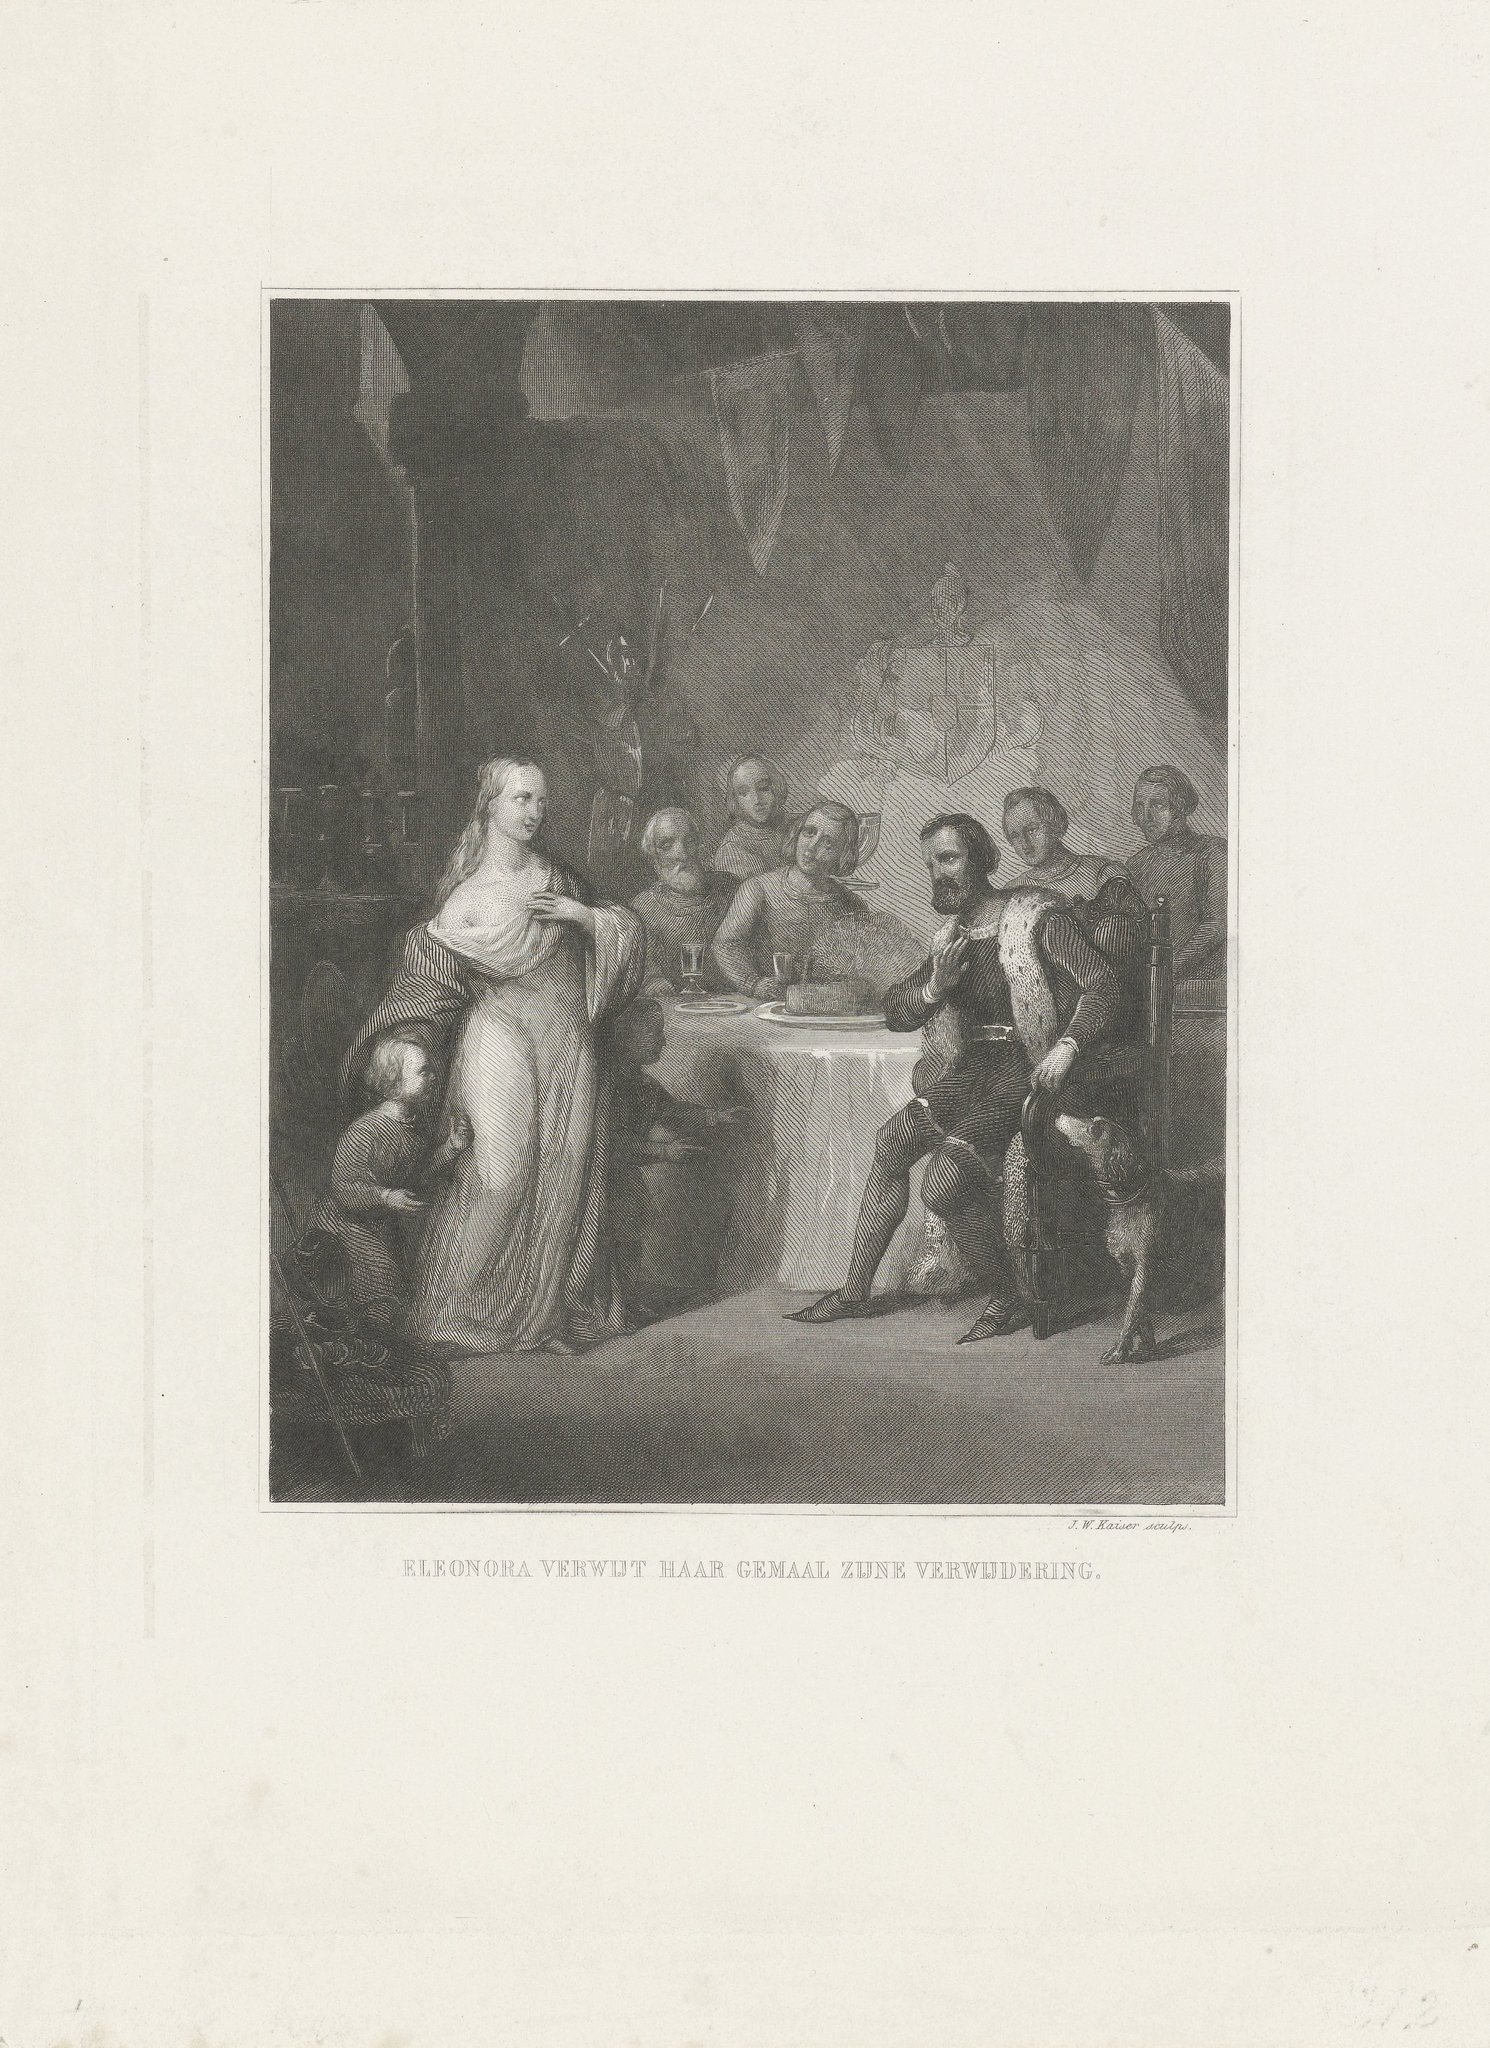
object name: book illustration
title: Eleonora verwijt haar gemaal zijne verwijdering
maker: johann wilhelm kaiser (i)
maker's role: draughtsman, print maker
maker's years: 1813-1900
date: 1840-1884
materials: paper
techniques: engraving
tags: arnhem, deventer, nijmegen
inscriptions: collector's mark: Lugt 2228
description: Eleonora van Engeland verwijt in Nijmegen haar man graaf Reinoud II van Gelre zijn verwijdering in het jaar 1342. Zij bewijst haar man dat zij niet melaats is en dat hij haar dus ten onrechte heeft verstoten. Zij voorspelt de ondergang van zijn huis, beide zonen die naast haar staan, zullen sneuvelen in de strijd om hun vaders naam.